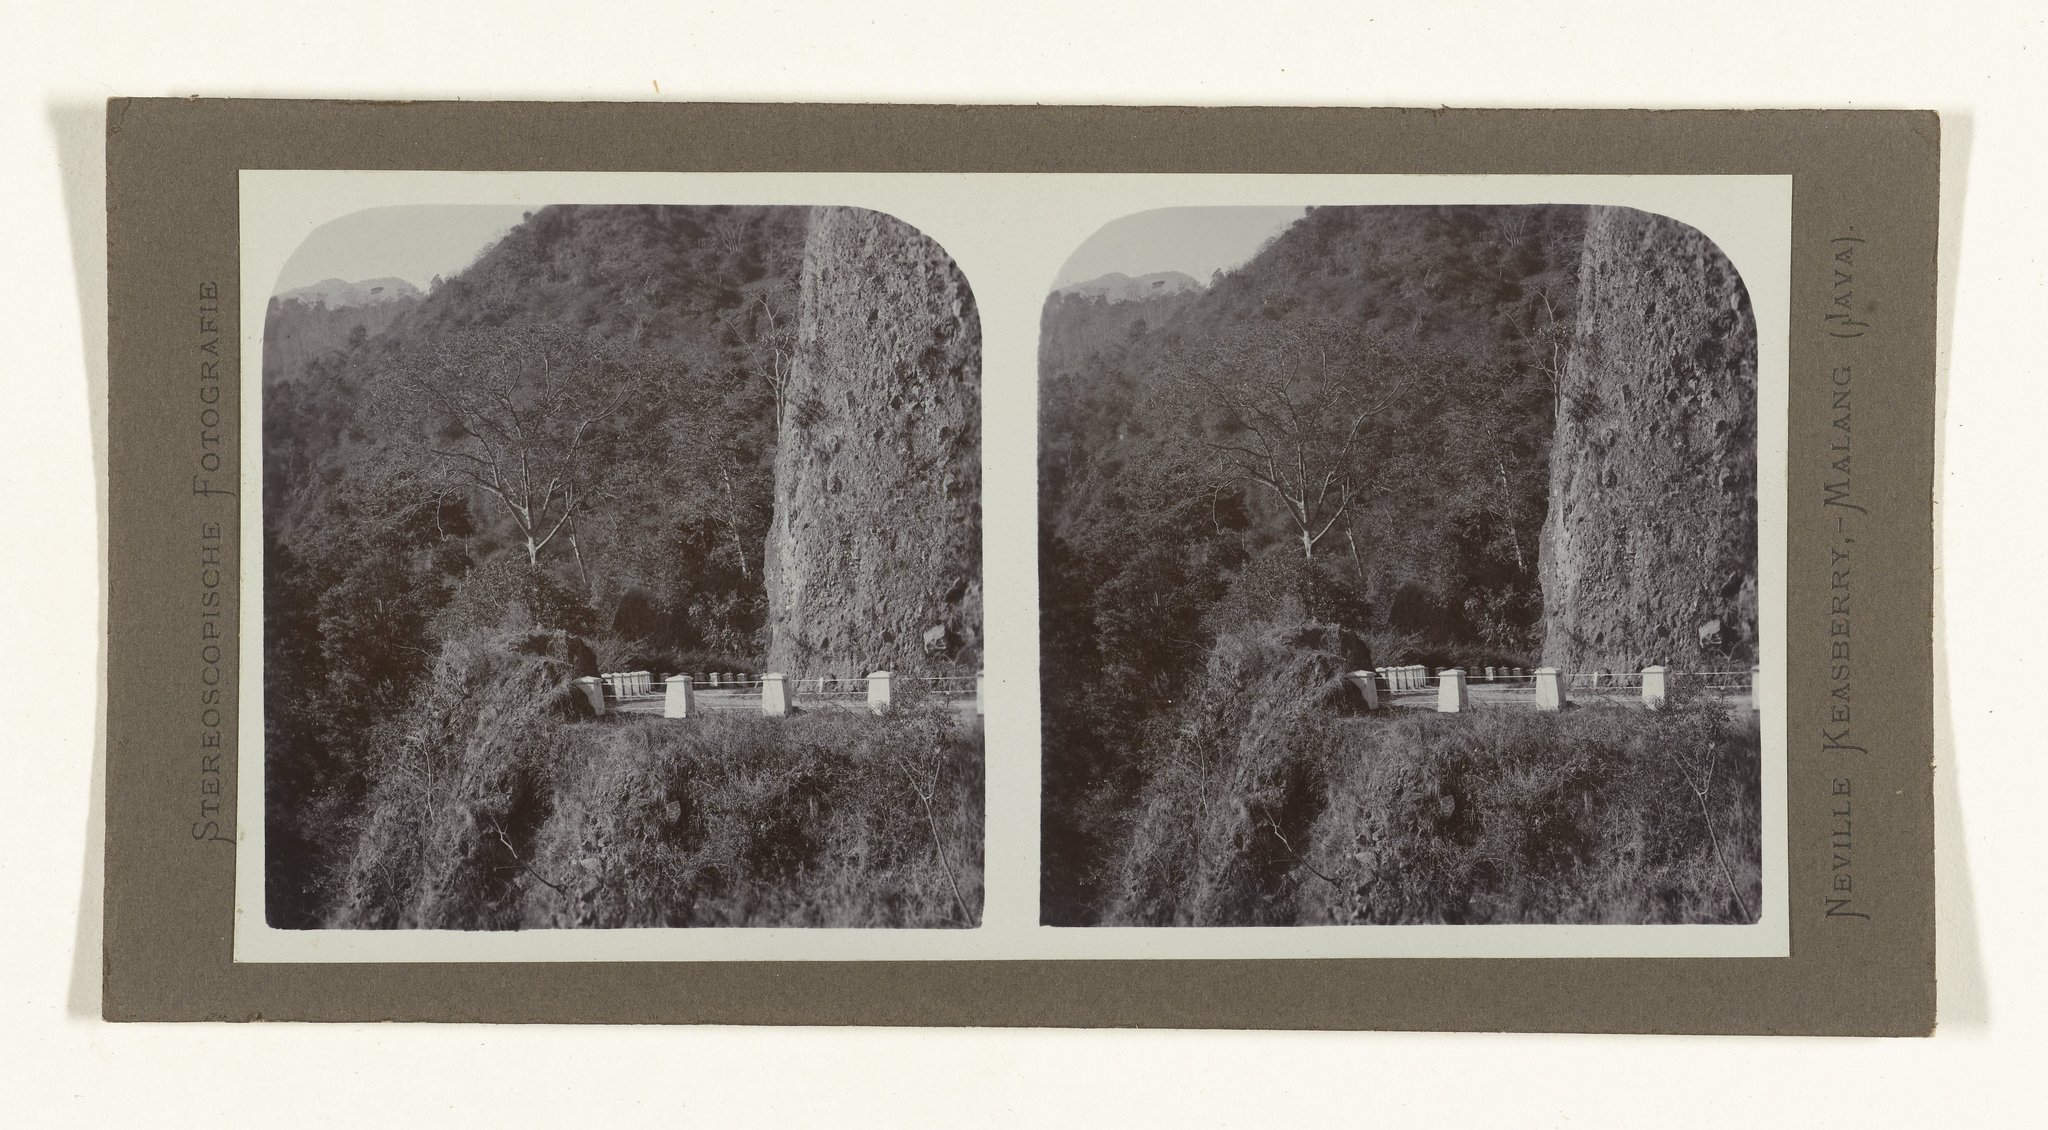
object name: stereograph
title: Geasfalteerde bergweg op Java.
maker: neville keasberry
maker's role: fotograaf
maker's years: 1866-1944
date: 1900-1935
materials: cardboard, paper, photographic support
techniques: albumen print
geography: malang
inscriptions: signature: ‘Neville Keasberry, Malang (Java)’, inscription: ‘Stereoscopische Fotografie’